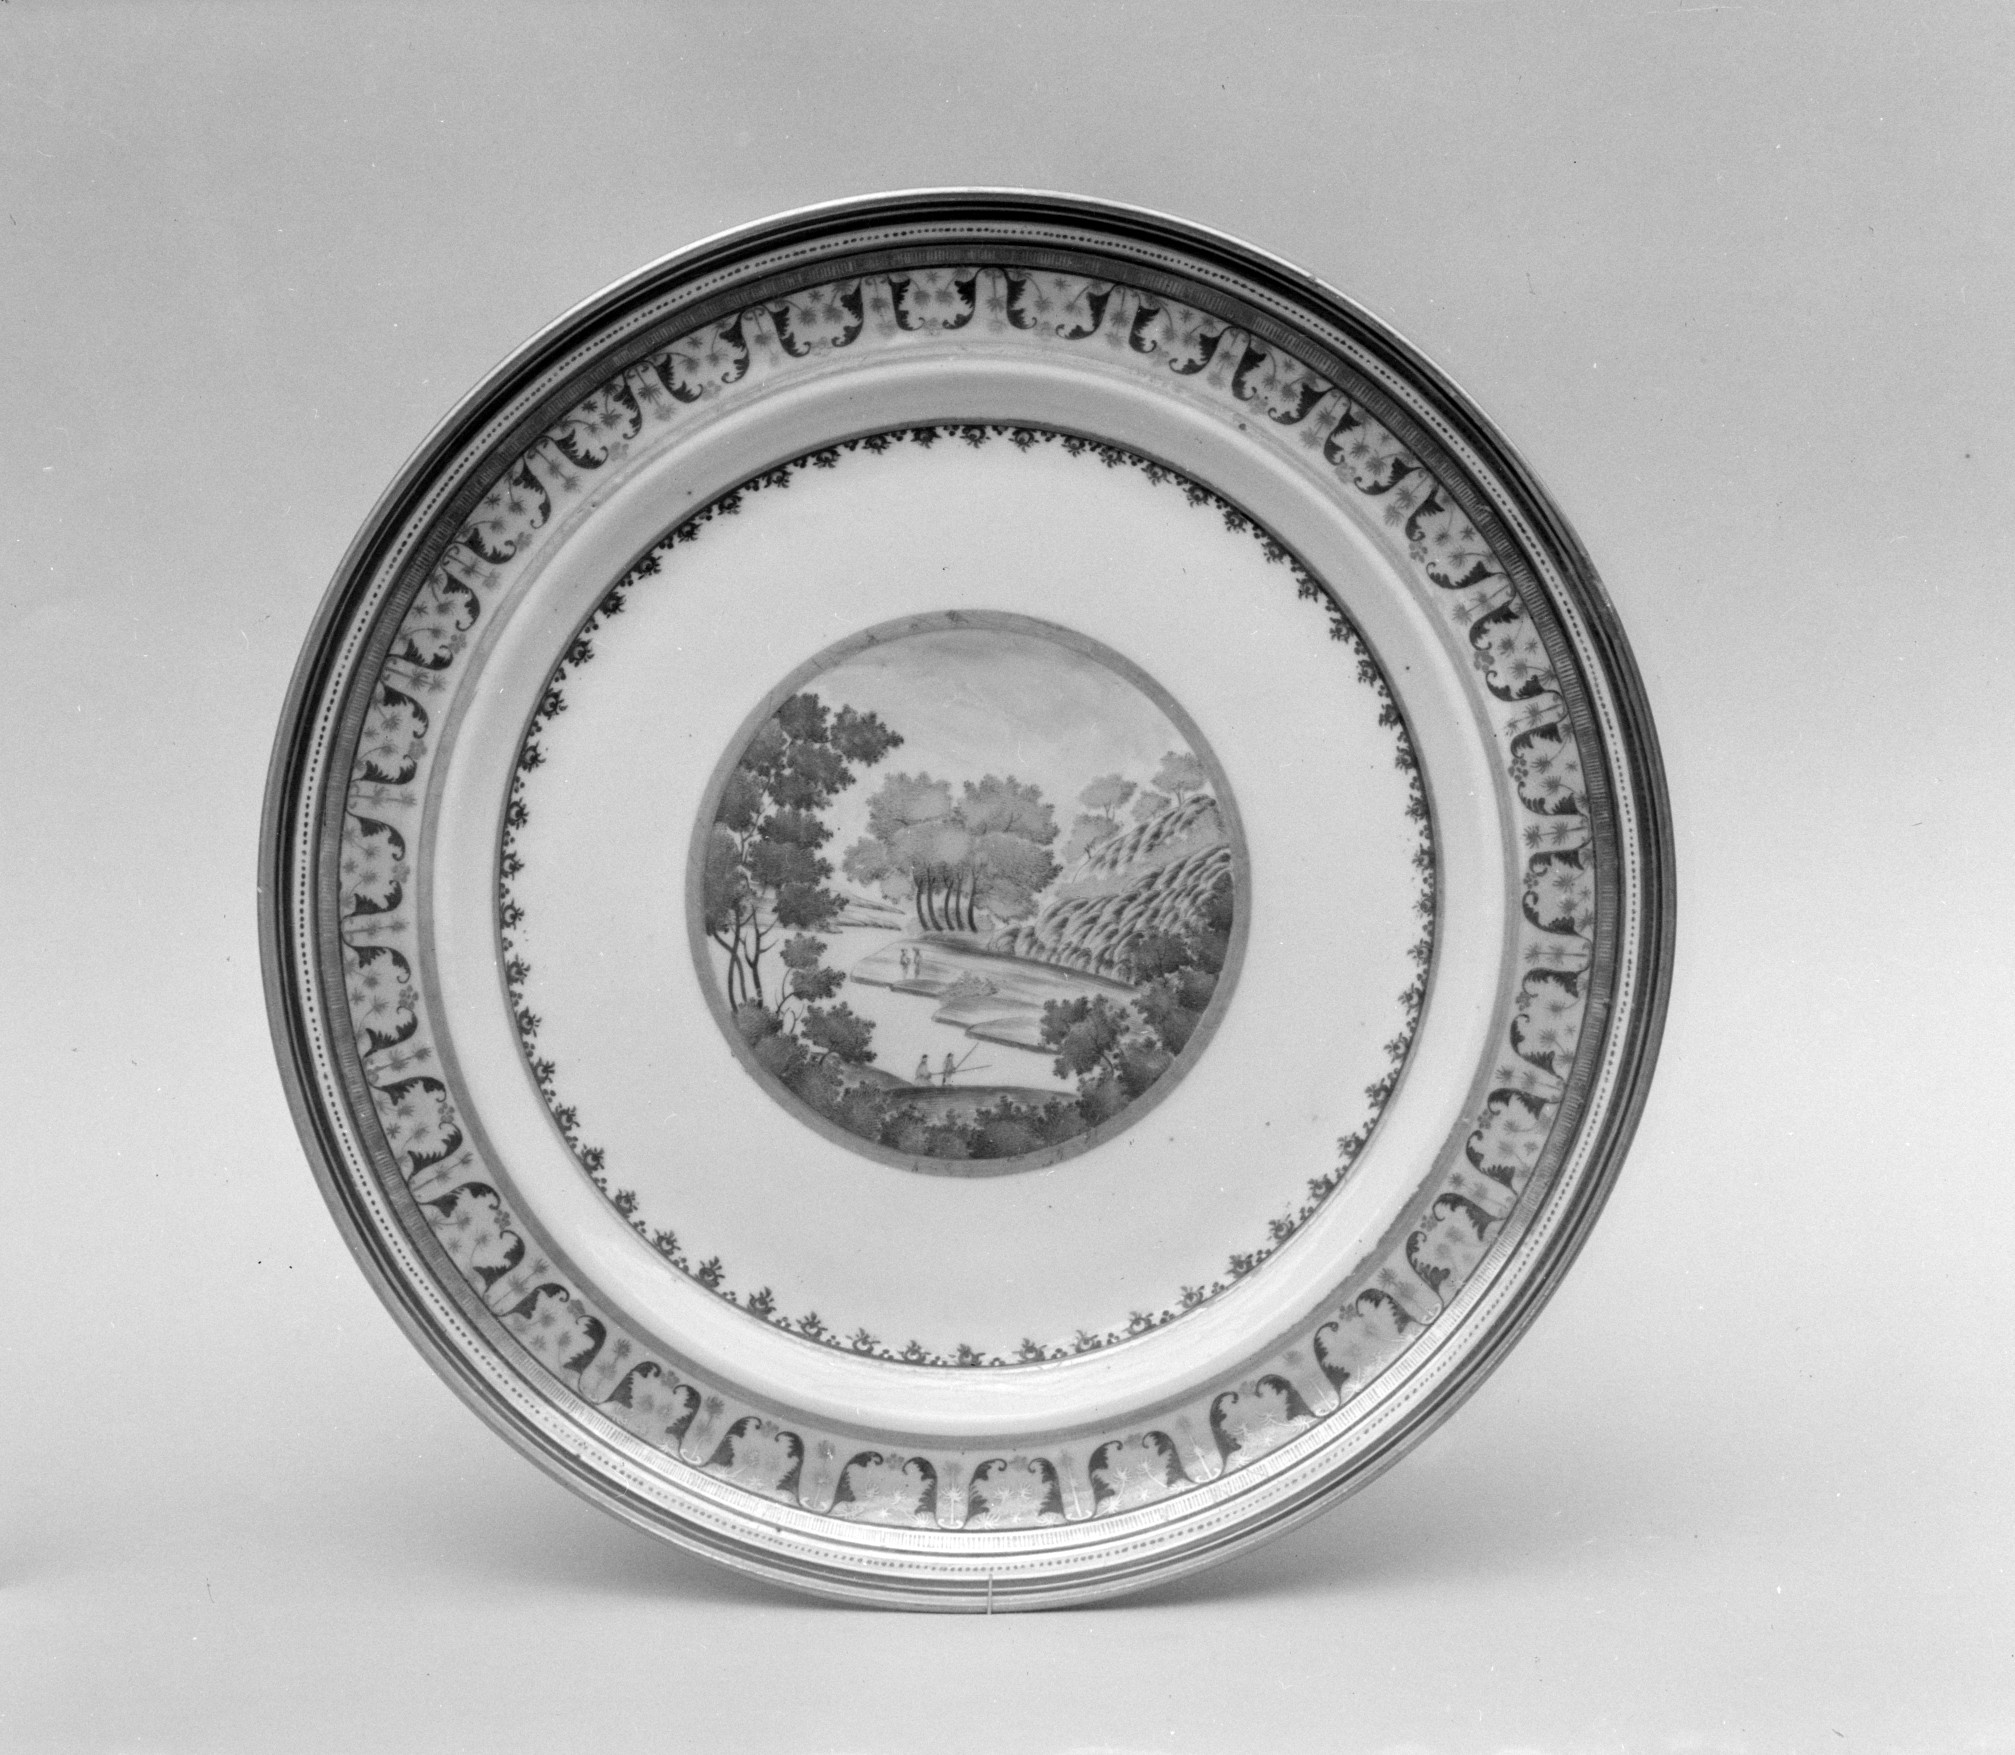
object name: plate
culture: chinese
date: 1800-1830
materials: porcelain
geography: china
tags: landscapes